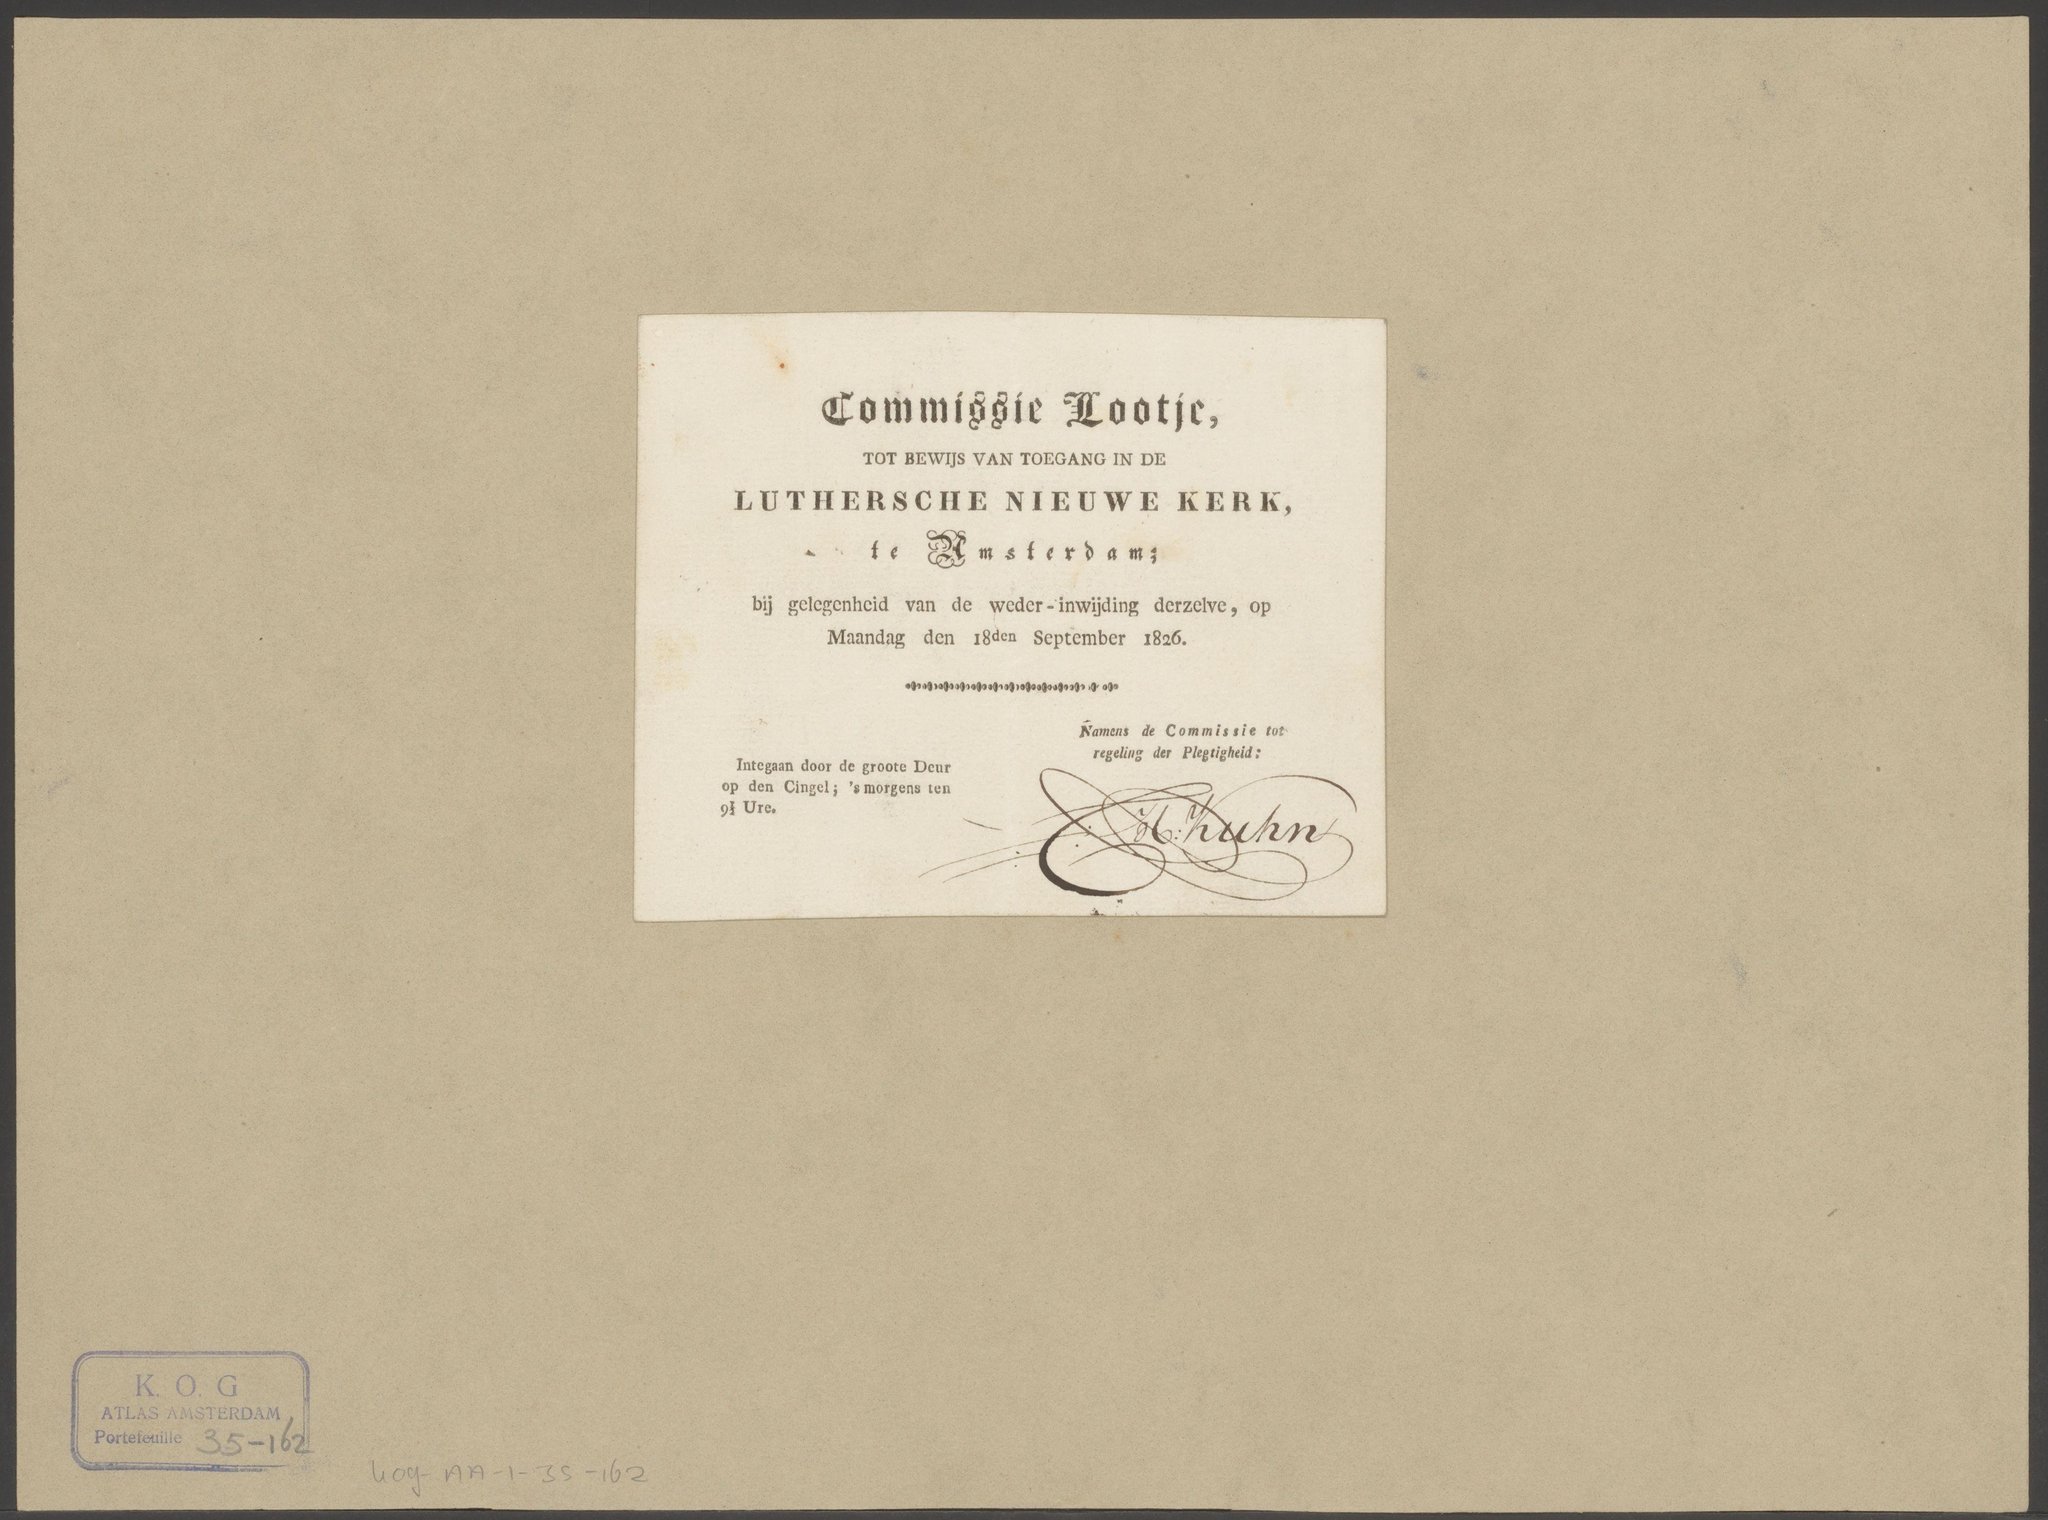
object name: admission ticket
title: Toegangsbewijs voor de inwijding van de herbouwde Nieuwe Lutherse Kerk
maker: Anonymous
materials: paper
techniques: engraving, etching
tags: singel, nieuwe lutherse kerk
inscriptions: collector's mark: Lugt 1641b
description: Toegangsbewijs voor de inwijding van de herbouwde Nieuwe Lutherse Kerk op 18 september 1826. De kerk is herbouwd na een grote brand op 18 september 1826. Onderwerpsrubriek binnen de Atlas Amsterdam: Kerkwezen: Ev. Lutherse Gemeente: Ronde Luthersche Kerk na de herbouwing.